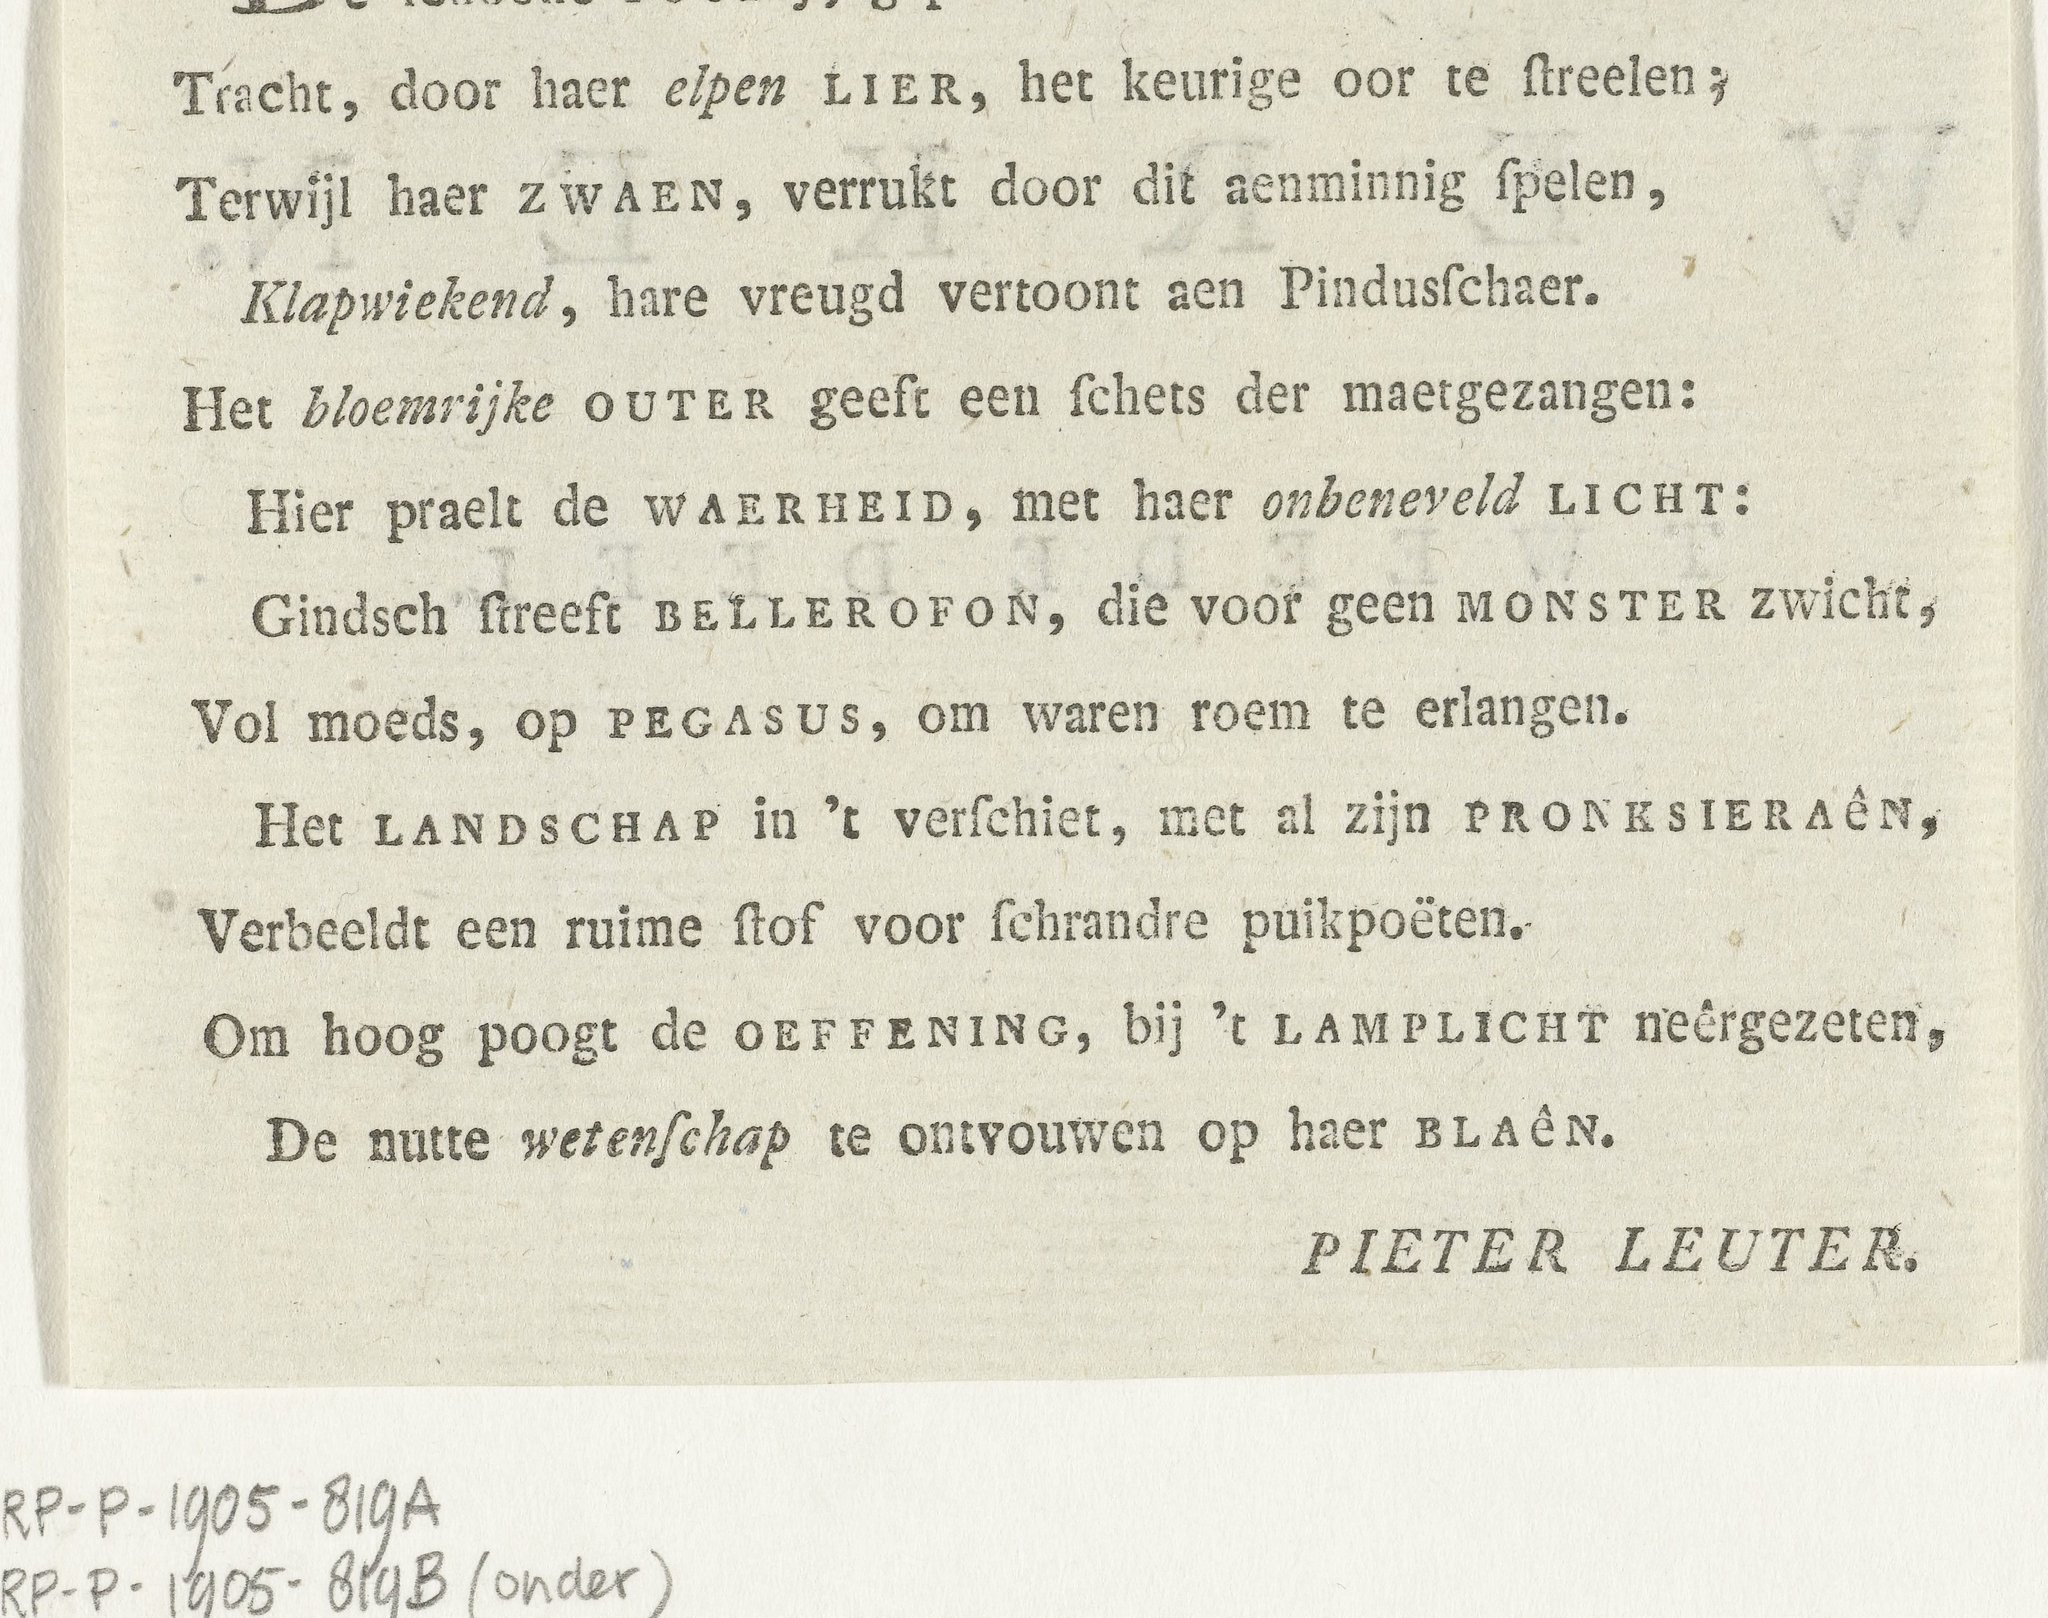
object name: print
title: Fragment met vers van Pieter Leuter en gedeelte van titel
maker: leendert brasser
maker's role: draughtsman, print maker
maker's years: 1727-1793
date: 1727-1793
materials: paper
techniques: etching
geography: rotterdam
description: Fragment uit de uitgave met een verklarend vers van Pieter Leuter bij het titelvignet en op de andere zijde een gedeelte van de titel.